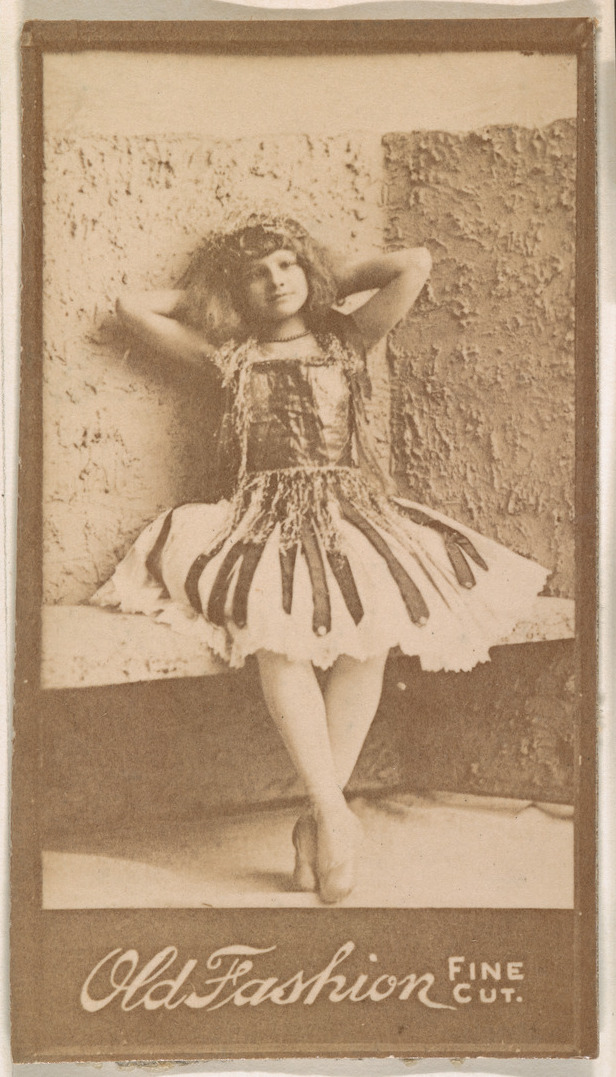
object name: photograph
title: Actress leaning against wall with hands behind head, from the Actresses series (N664) promoting Old Fashion Fine Cut Tobacco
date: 1888-1890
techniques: albumen silver print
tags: portraits,women,actresses